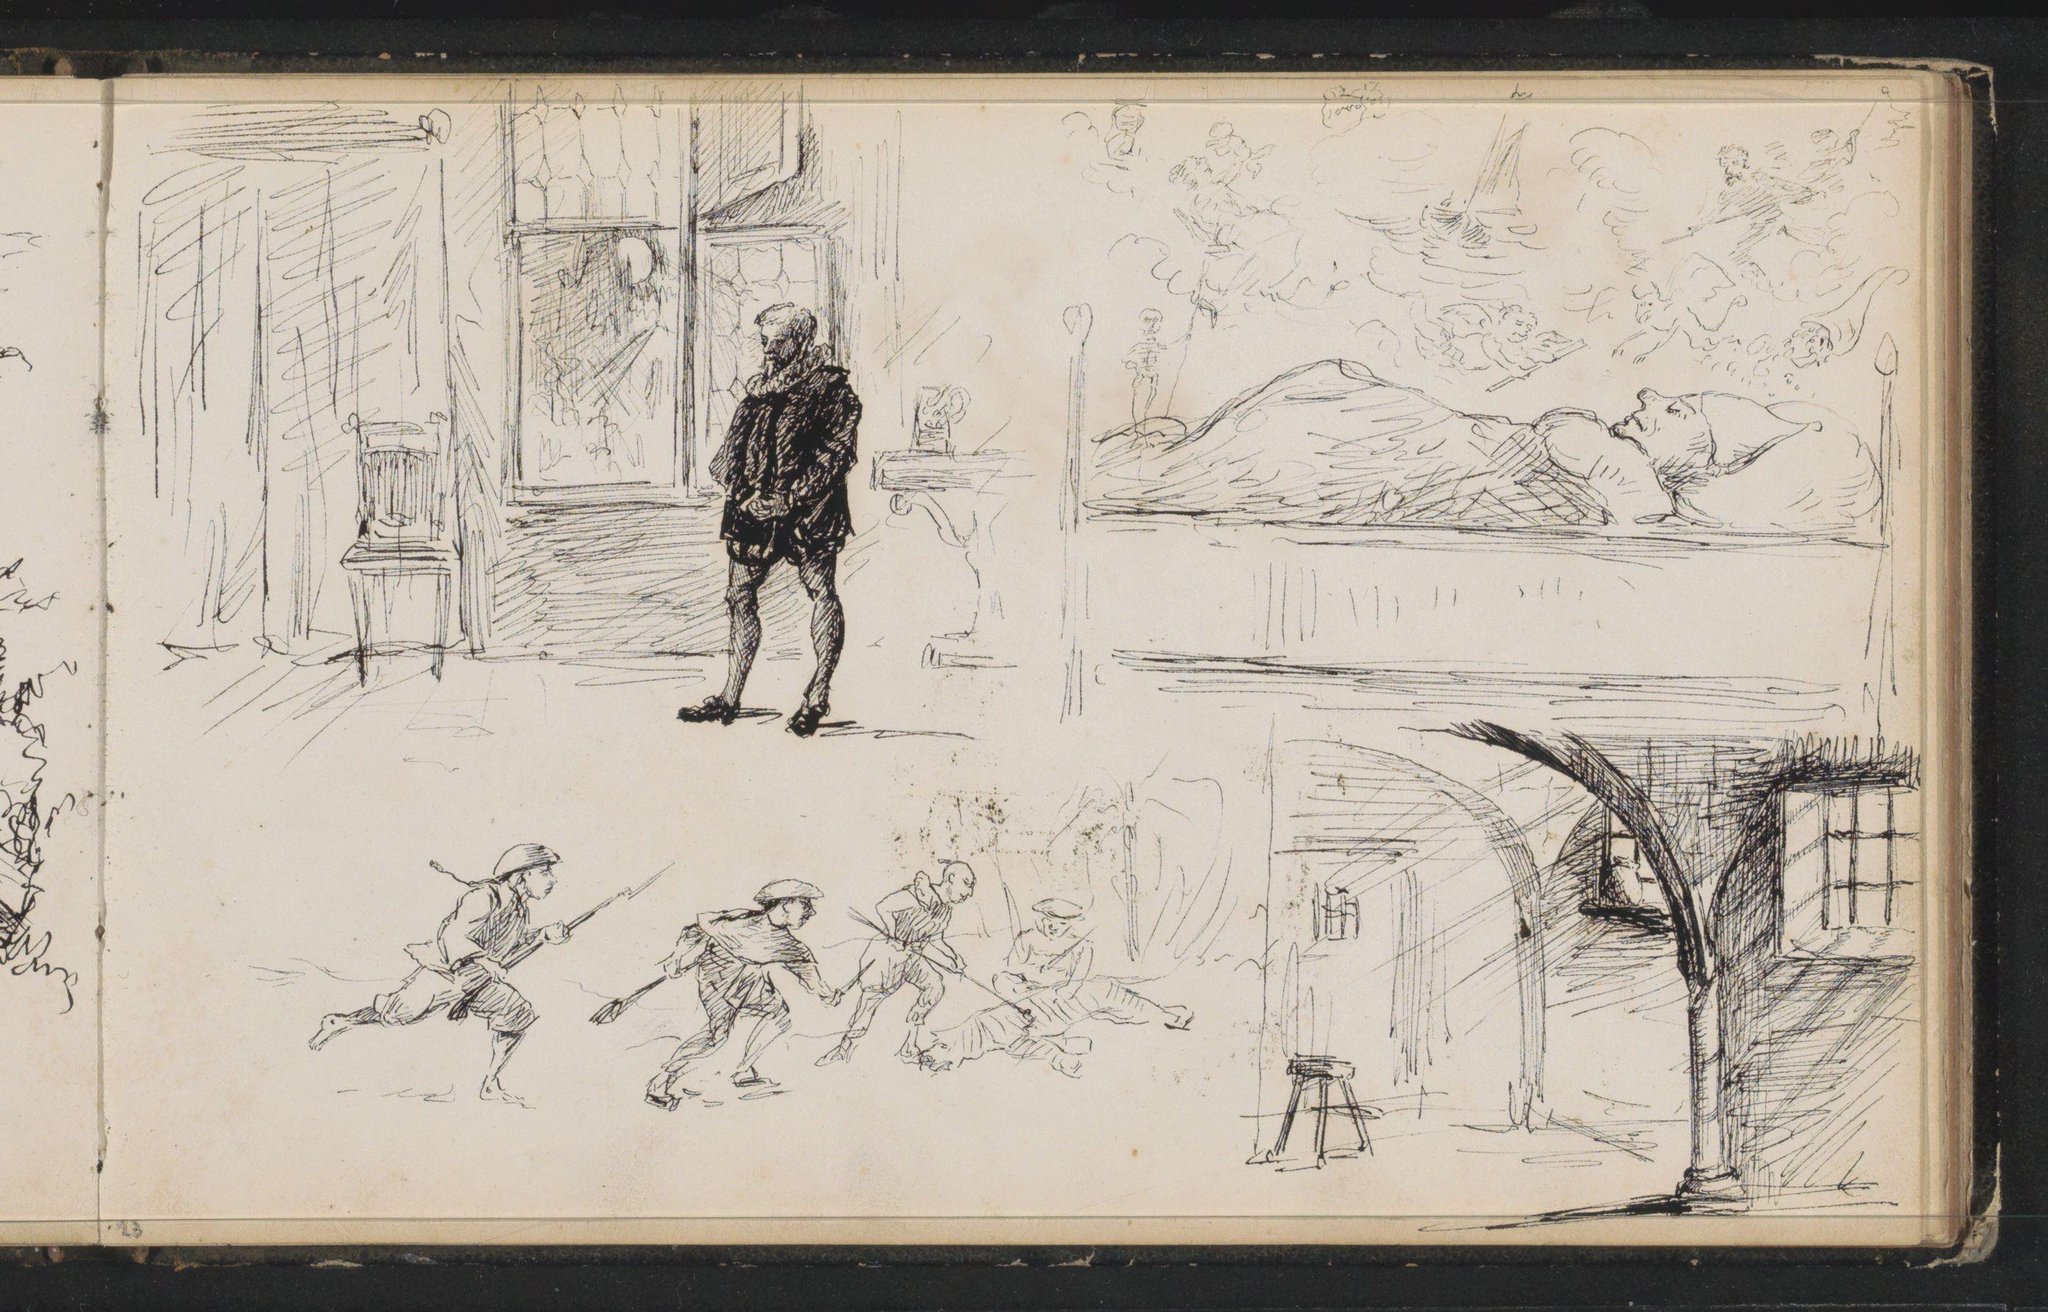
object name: sketchbook leaf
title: Studieblad, onder andere met een man in zeventiende-eeuws kostuum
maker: marius bauer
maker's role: draughtsman, print maker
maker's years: 1867-1932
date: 1812-1880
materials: paper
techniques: pen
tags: standing figure, neck-gear ~ clothing (with name), adult man, sleeping in bed, interior of the house, dream, (military) uniforms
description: De man draagt een plooikraag en staat in een interieur bij het raam. Tevens een studie van engelen en een geraamte (etc.) bij het bed van een slapende man, militairen en een interieur met een kruk. Pagina 23 uit een schetsboek met 34 bladen.